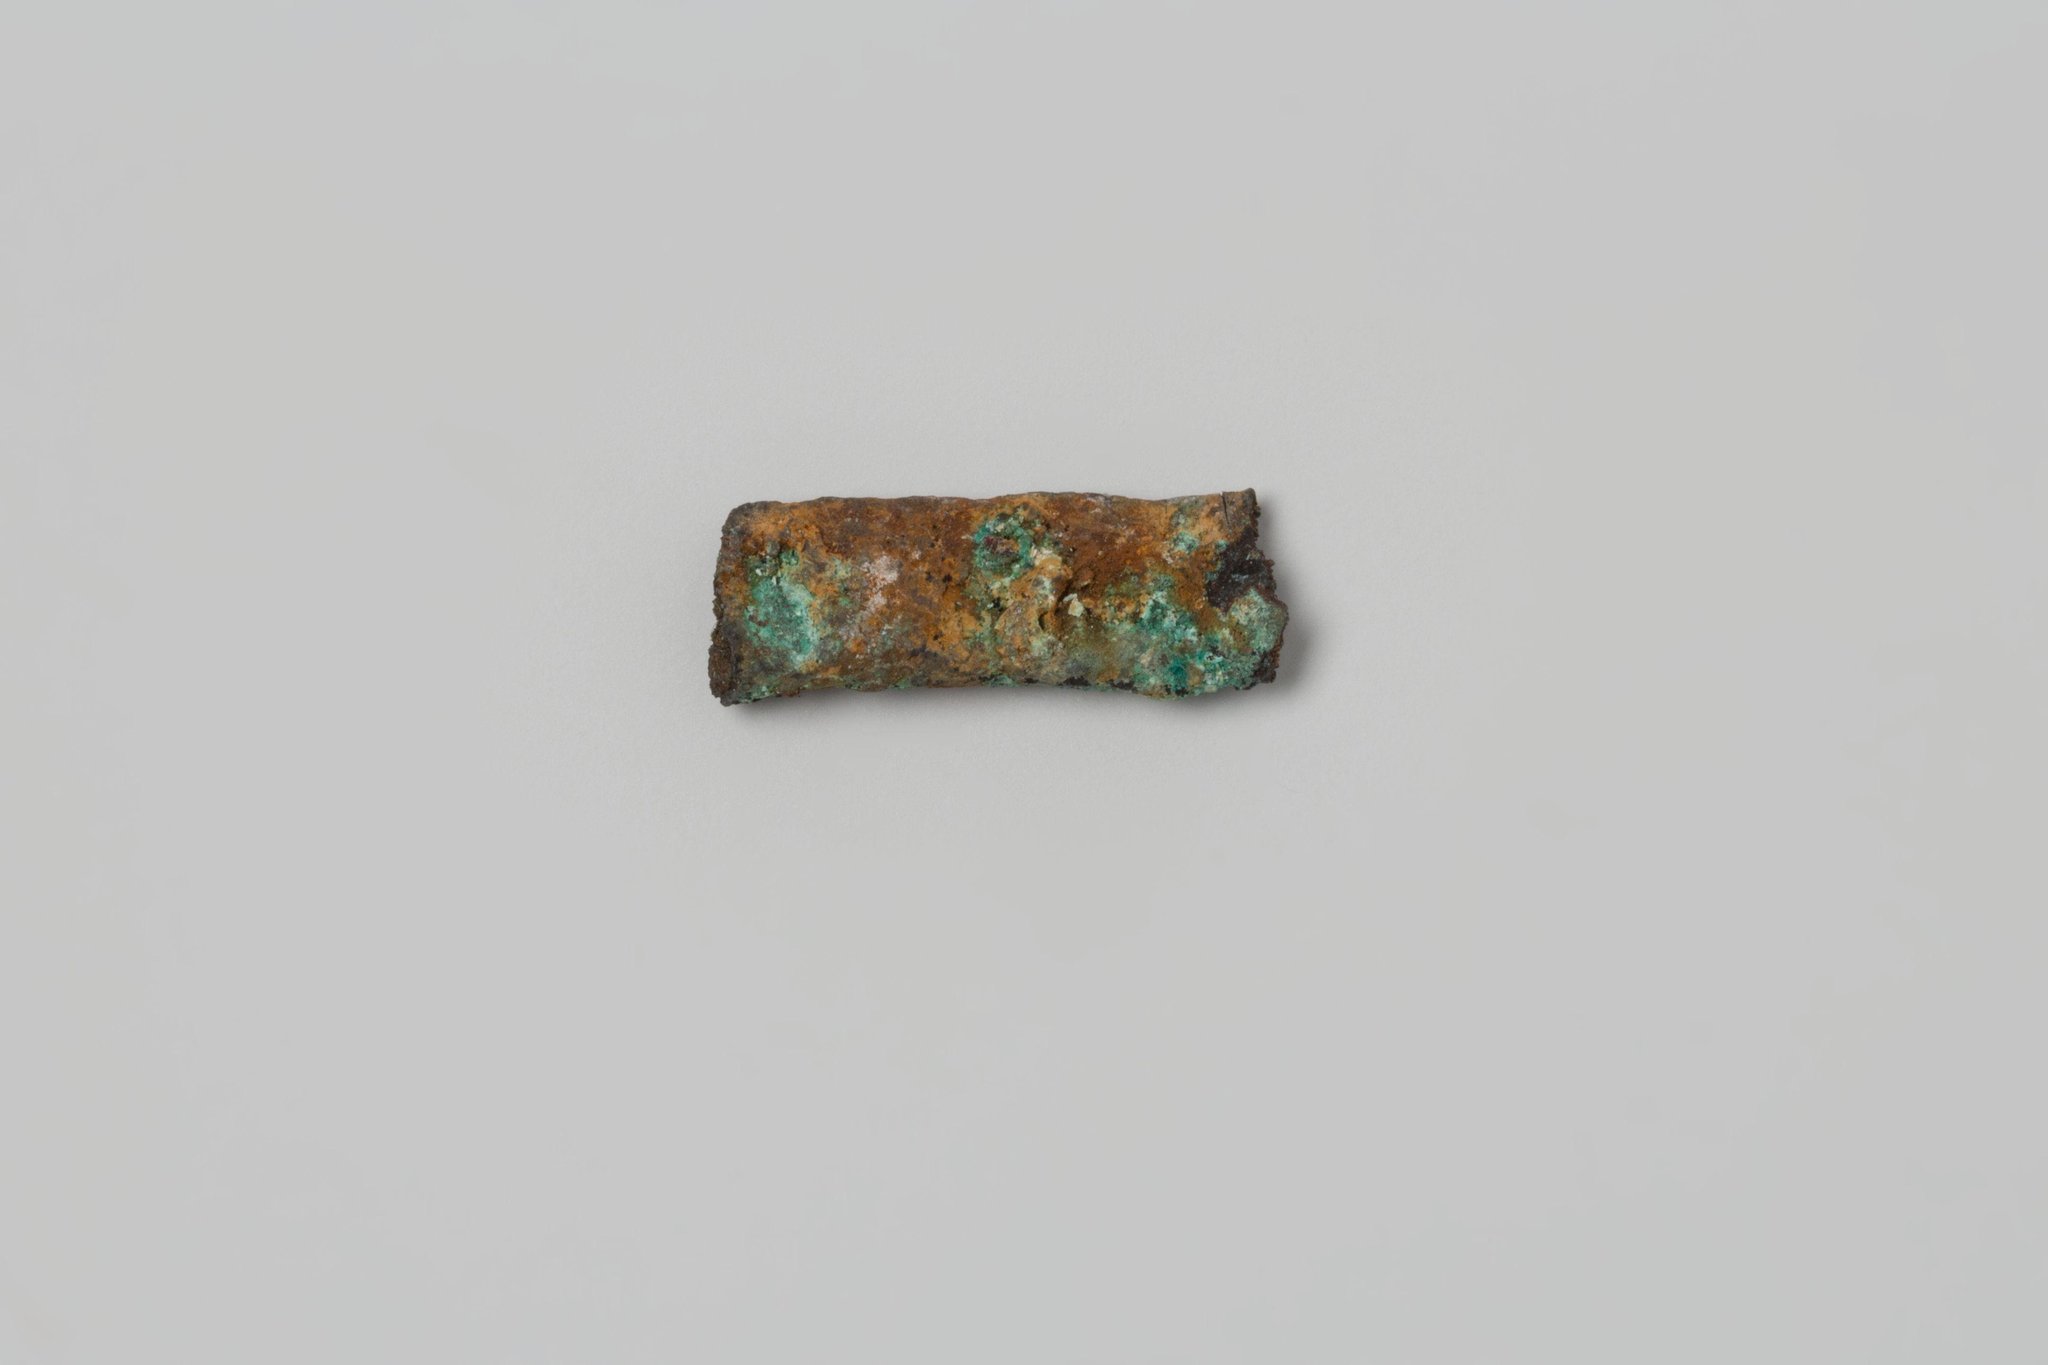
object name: belt buckle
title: Fragment riemgesp uit het wrak van de Oost-Indiëvaarder Hollandia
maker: Anonymous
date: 1700-1743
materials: copper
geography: netherlands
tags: verenigde oostindische compagnie, hollandia (schip), annet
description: Belt buckle, rectangular, fragm of ring, id. NG 1980-27H2796.